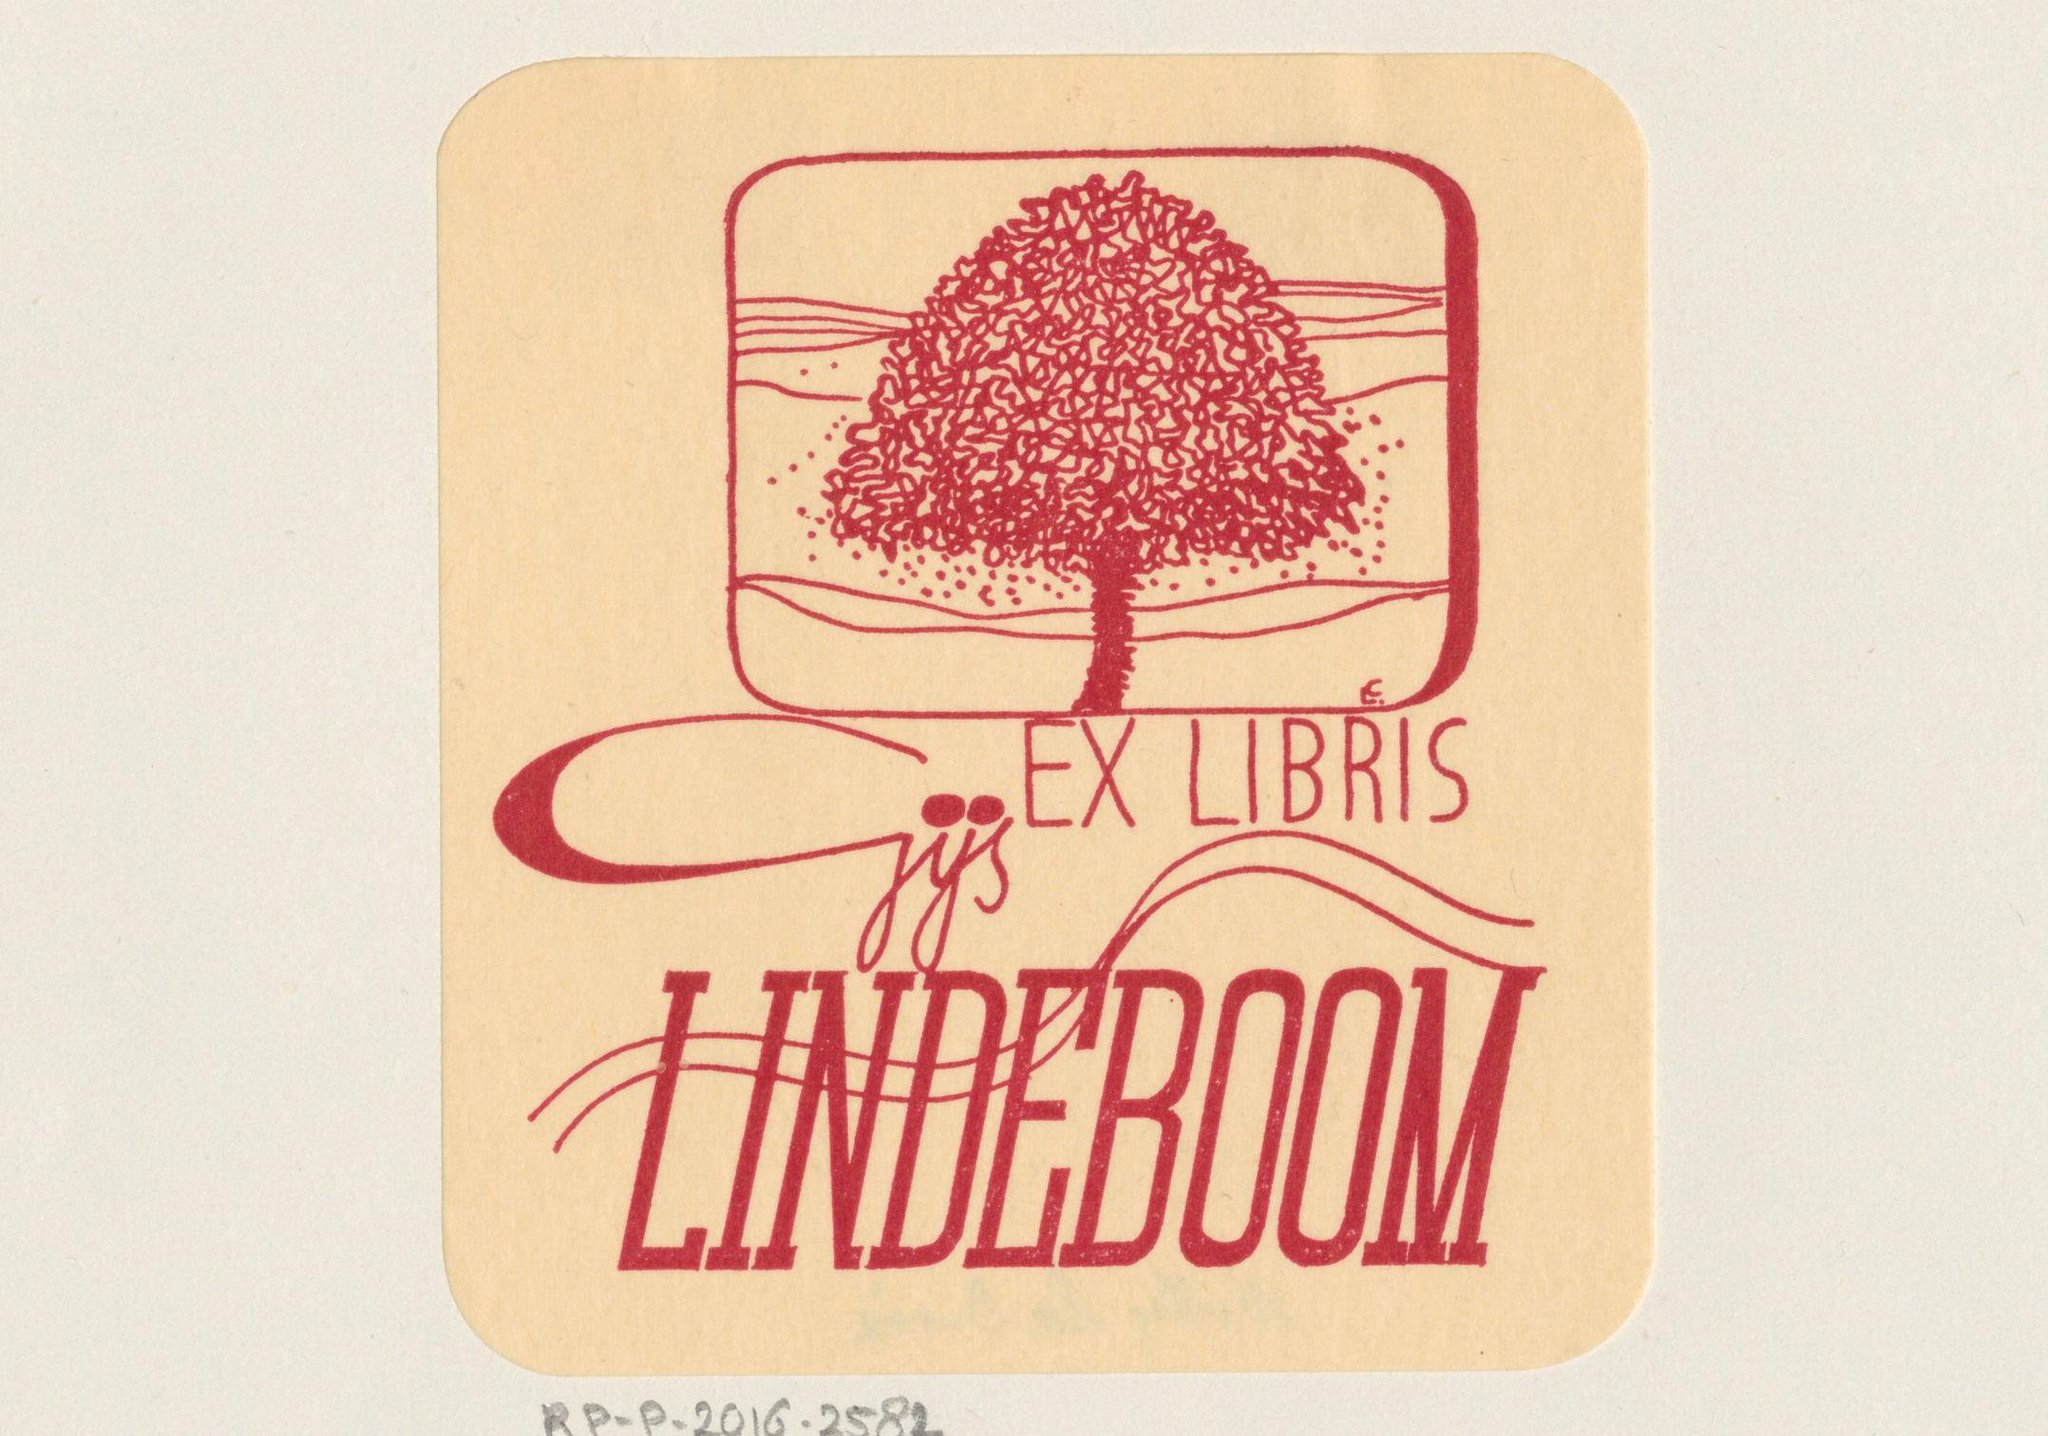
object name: bookplate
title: Ex libris van Gijs Lindeboom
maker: willy la croix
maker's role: print maker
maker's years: 1906-1944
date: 1937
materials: paper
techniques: printing block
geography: netherlands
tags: trees: linden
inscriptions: signature: ‘Willy la Croix’